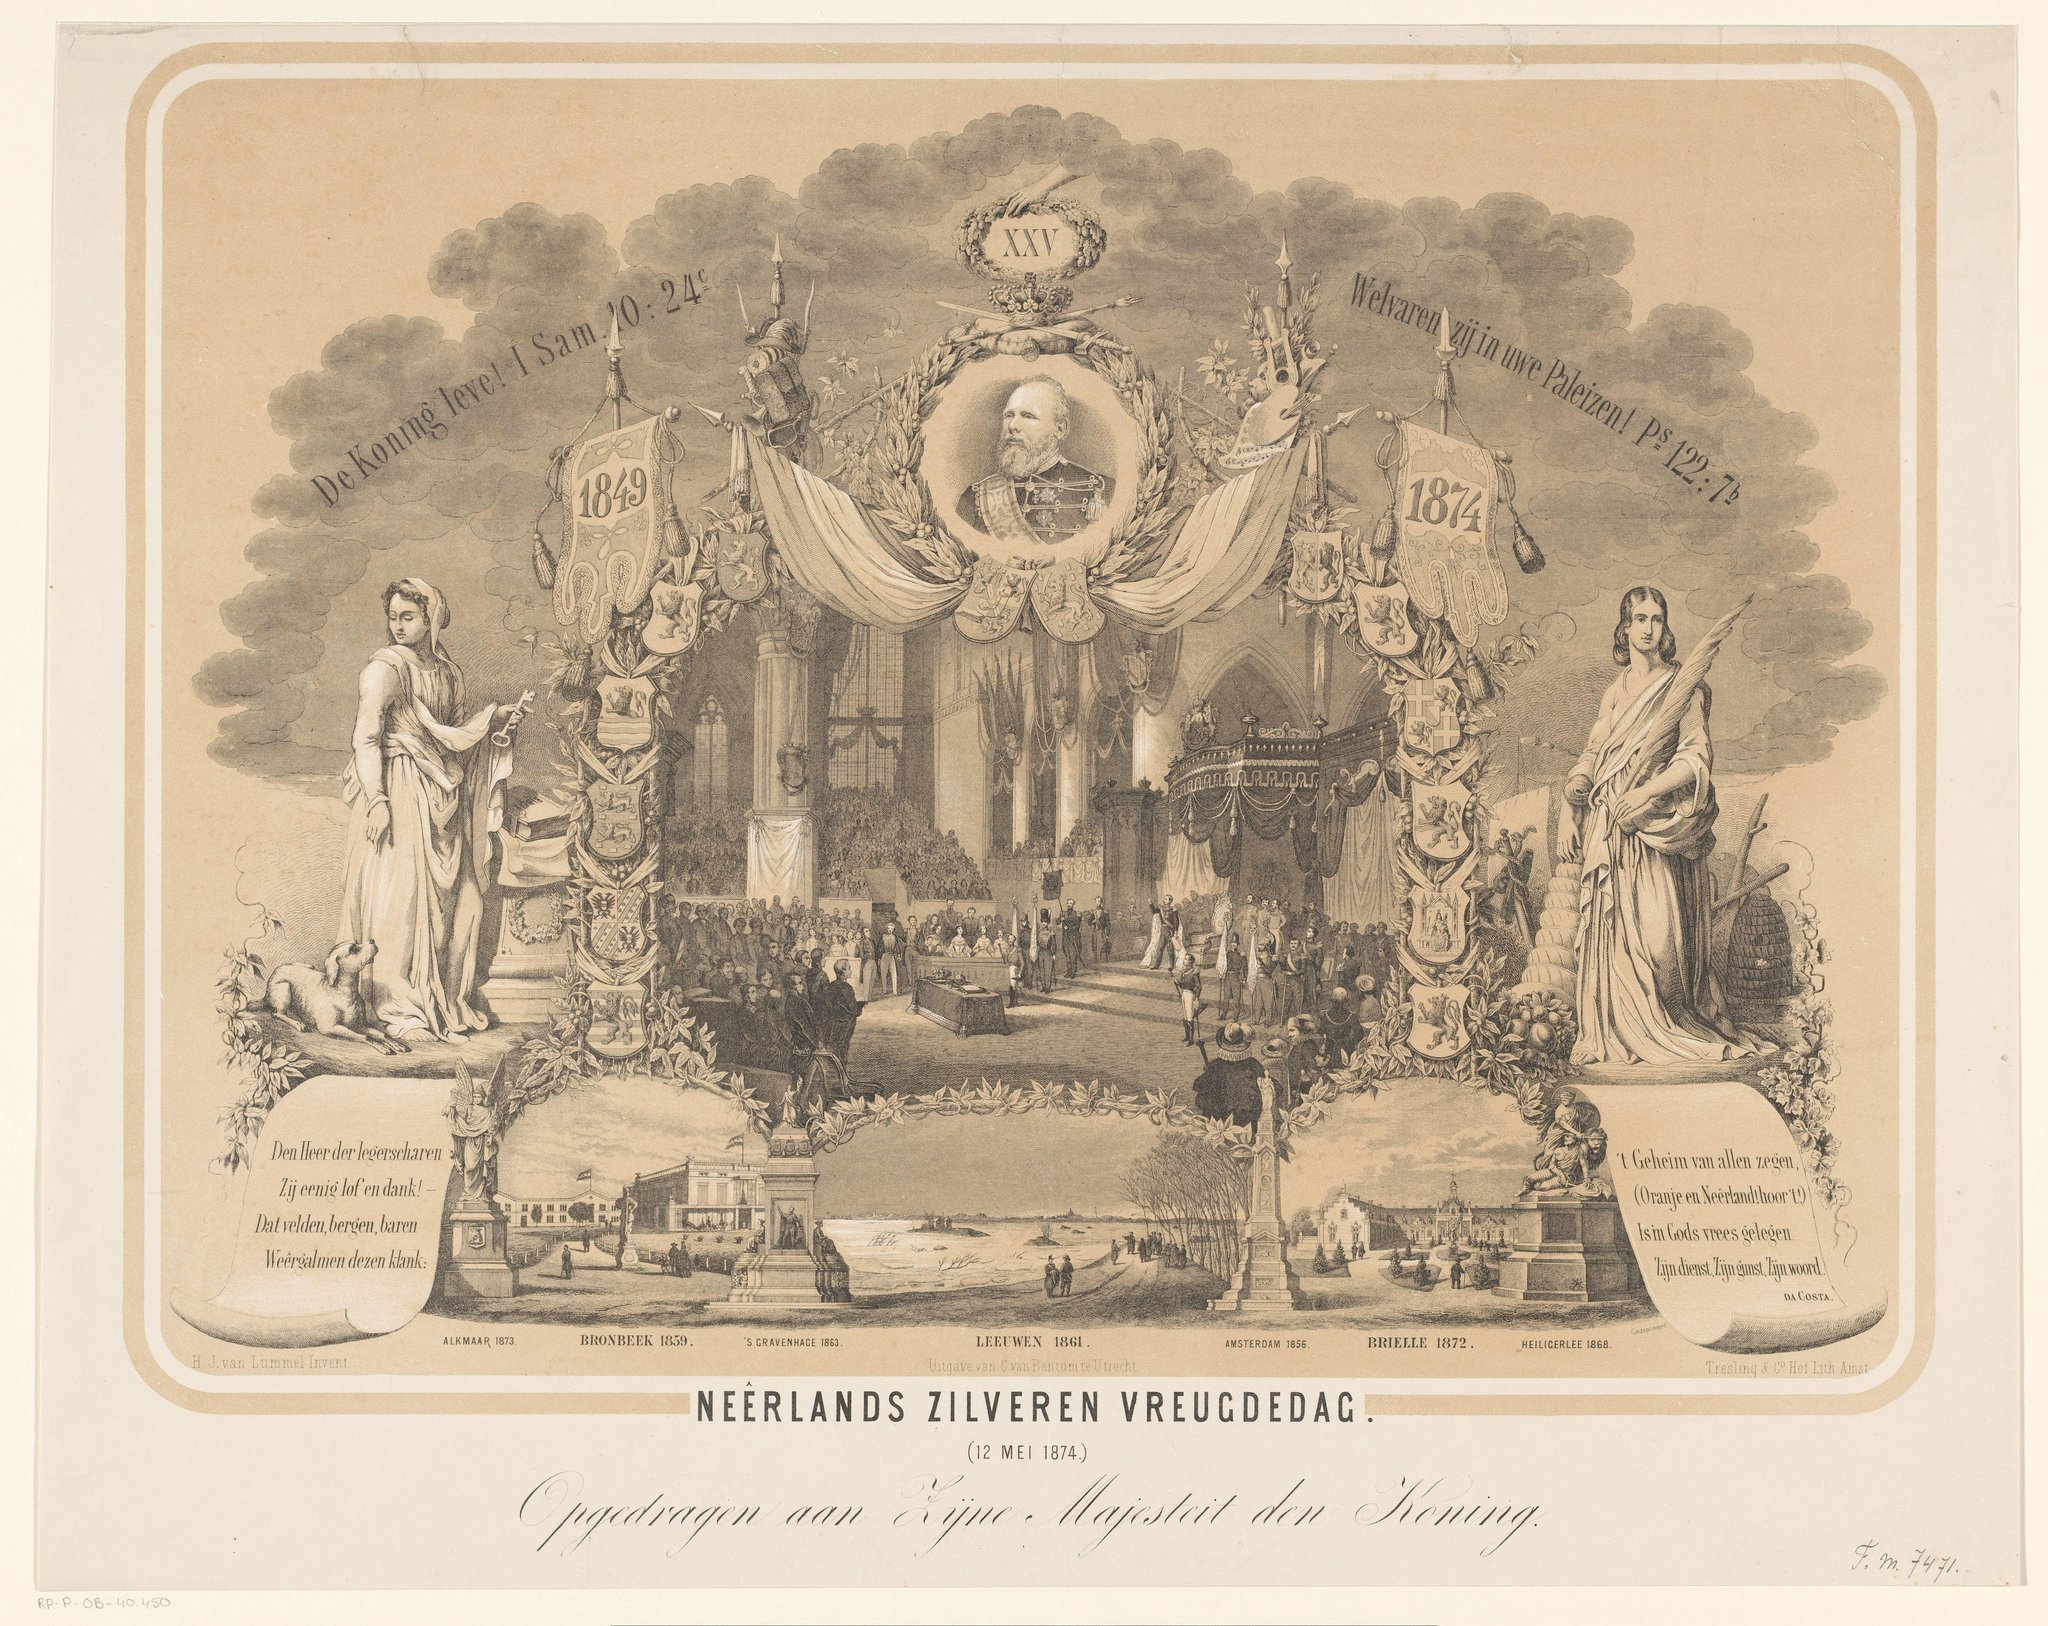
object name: print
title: Neêrlands Zilveren Vreugdedag. (12 Mei 1874.)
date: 1874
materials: paper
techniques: tone lithography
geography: netherlands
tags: brussels, willem iii (koning der nederlanden), new ruler taking the oath, the hague, amsterdam, brielle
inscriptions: collector's mark: Lugt 2228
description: Gedenkplaat bij de viering van het 25-jarige regeringsjubileum van koning Willem III, 12 mei 1874. Centraal de inhuldiging van koning Willem III in de Nieuwe Kerk te Amsterdam op 12 mei 1849. Aan weerszijden allegorische vrouwenfiguren. Onderaan drie scènes: Bronbeek gesticht door de koning in 1859, het bezoek van de koning aan het door watersnood getroffen Leeuwen in 1861 en het in 1872 opgerichte Zeemanshuis te Brielle. Tussen deze scènes de monumenten opgericht te Alkmaar in 1873, 's-Gravenhage 1863, Amsterdam 1856 en Heiligerlee 1868. Bovenaan een portret van Willem III. Met verschillende Bijbelcitaten en andere verzen.